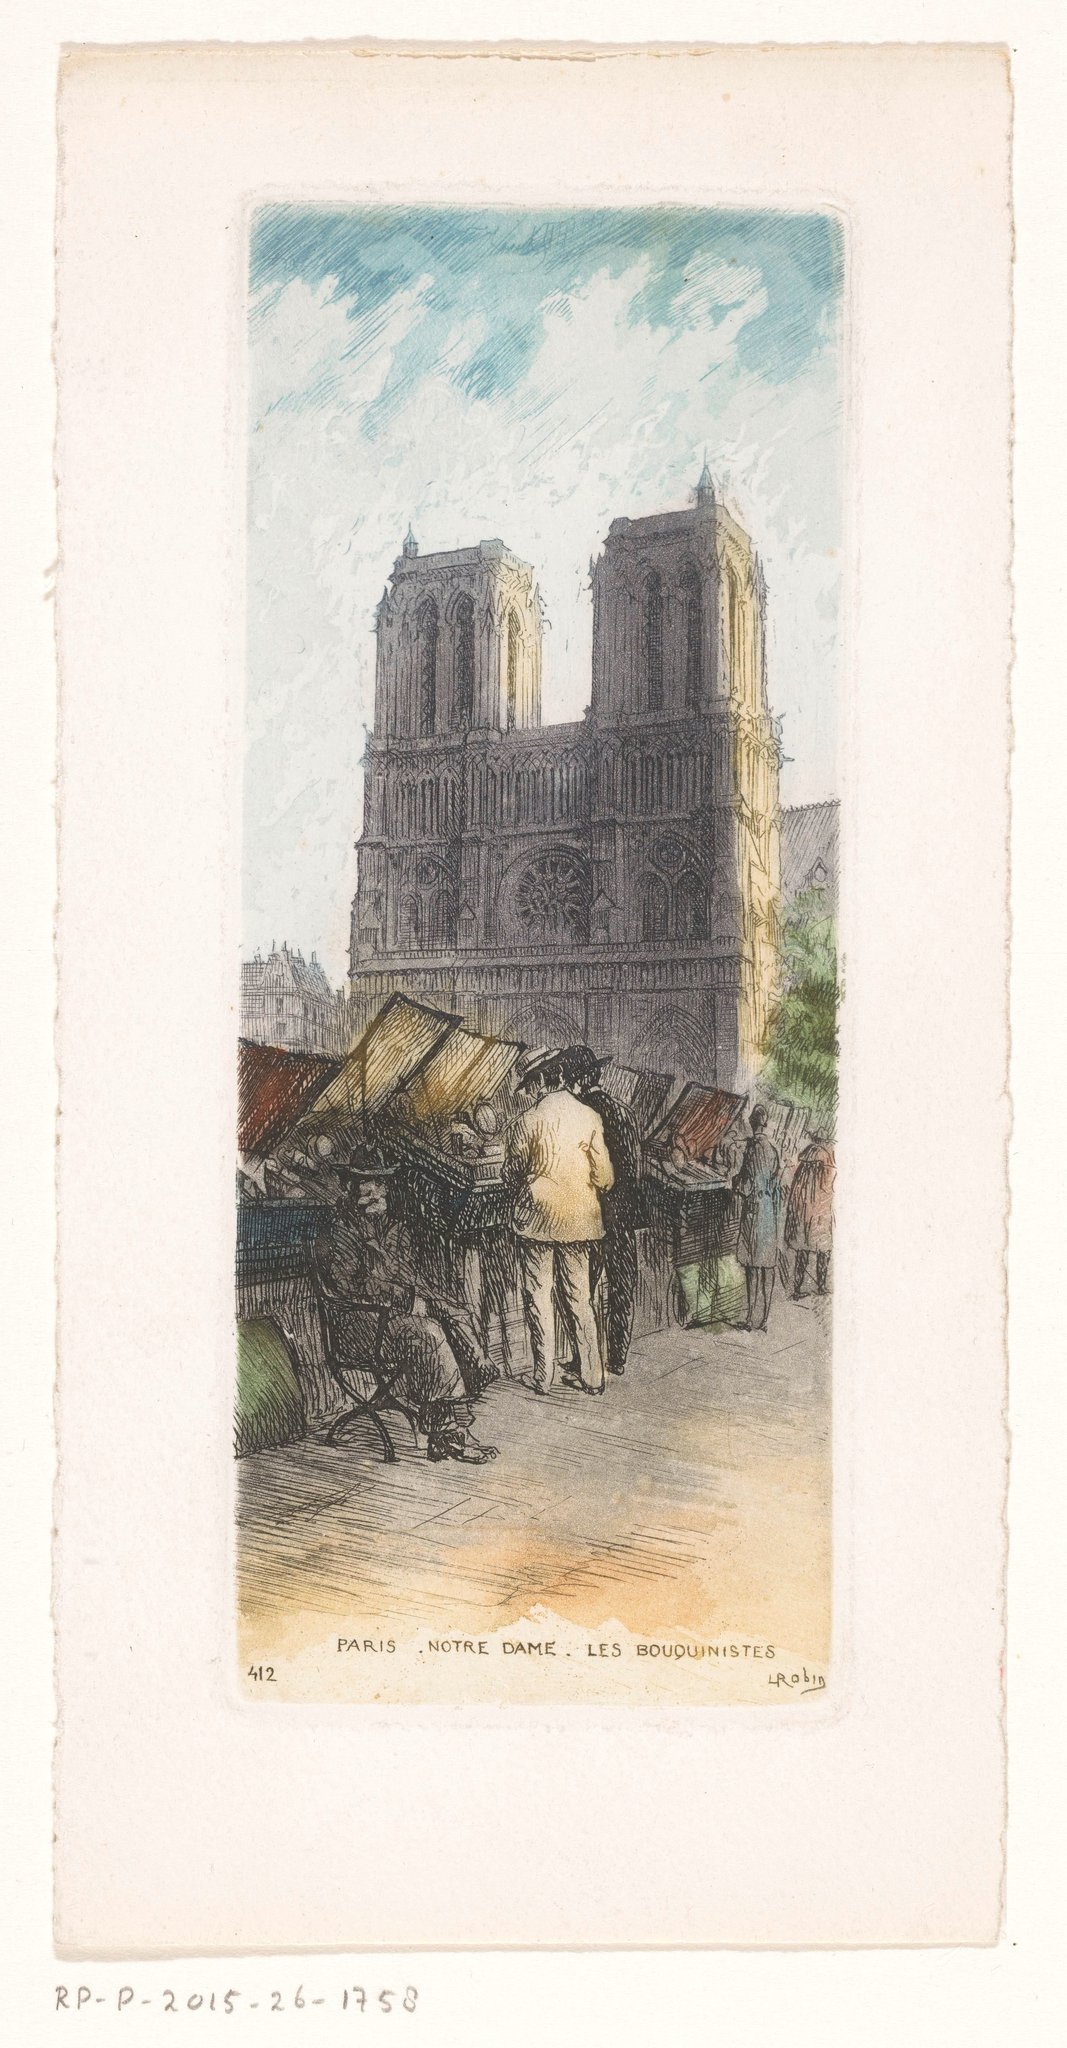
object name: print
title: Gezicht op de Notre-Dame te Parijs met boekhandelaren in de voorgrond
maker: léopold robin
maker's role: print maker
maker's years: 1877-1939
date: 1887-1939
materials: paper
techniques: aquatint, etching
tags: book-stall, kiosk, roman catholic church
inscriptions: collector's mark: Lugt 2228